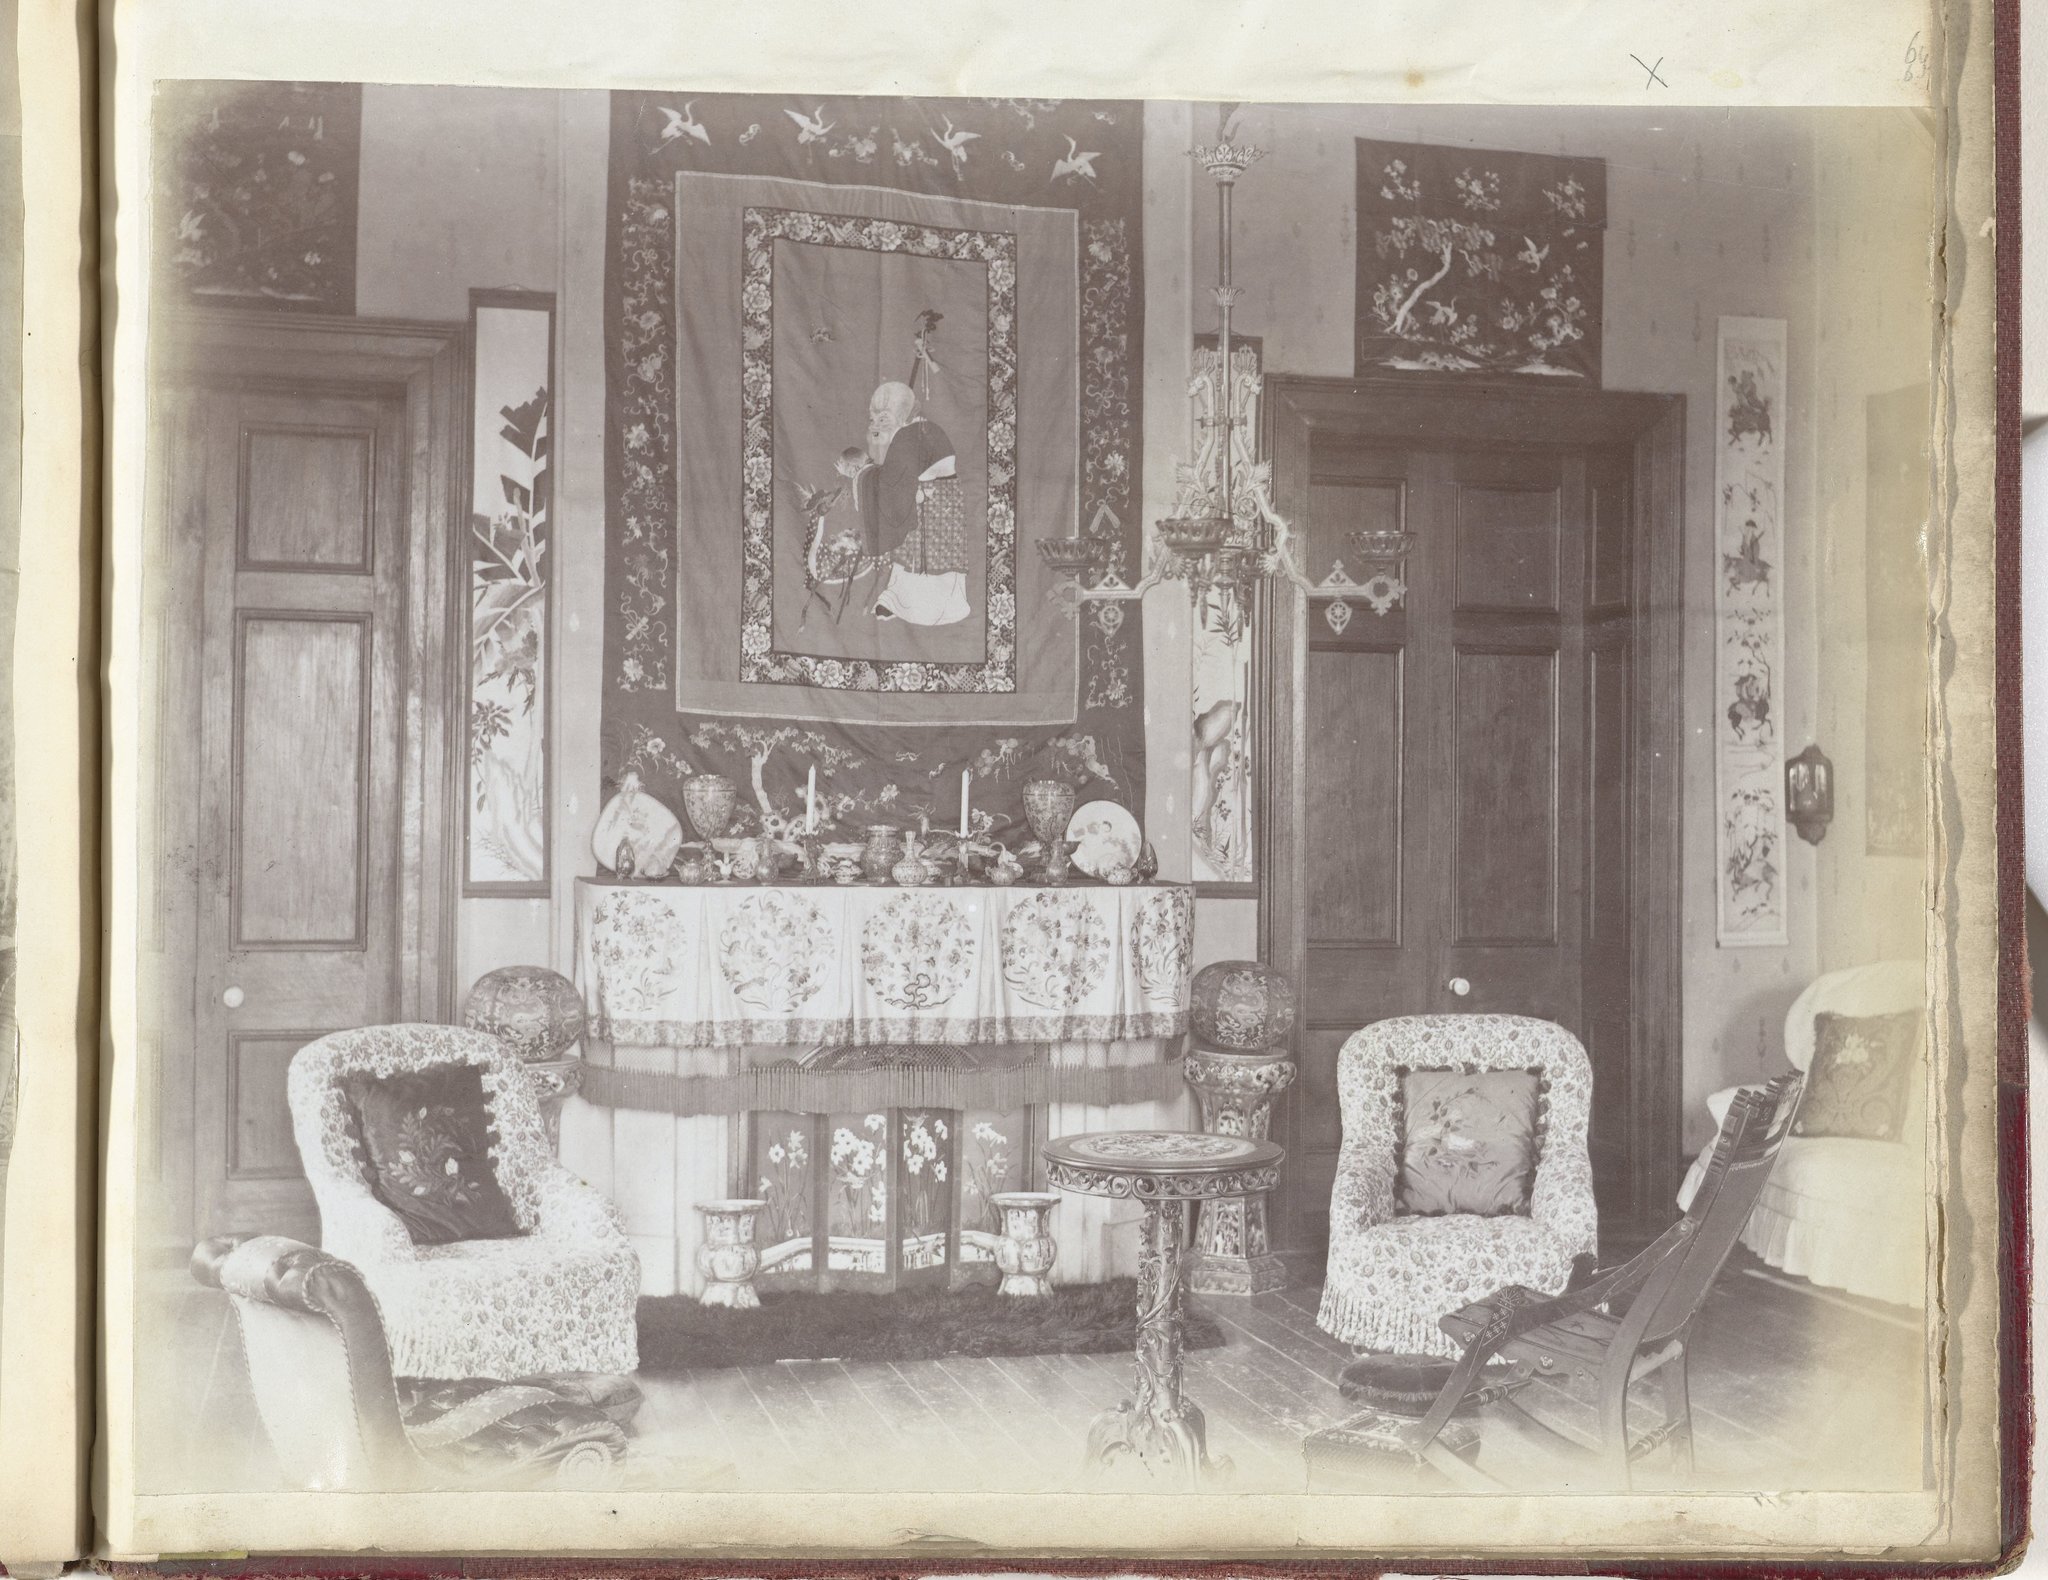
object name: photograph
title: Interieur van een zitkamer met een wandtapijt, China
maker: Anonymous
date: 1879-1890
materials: paper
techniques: albumen print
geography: china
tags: living-room, parlour, sitting-room, china